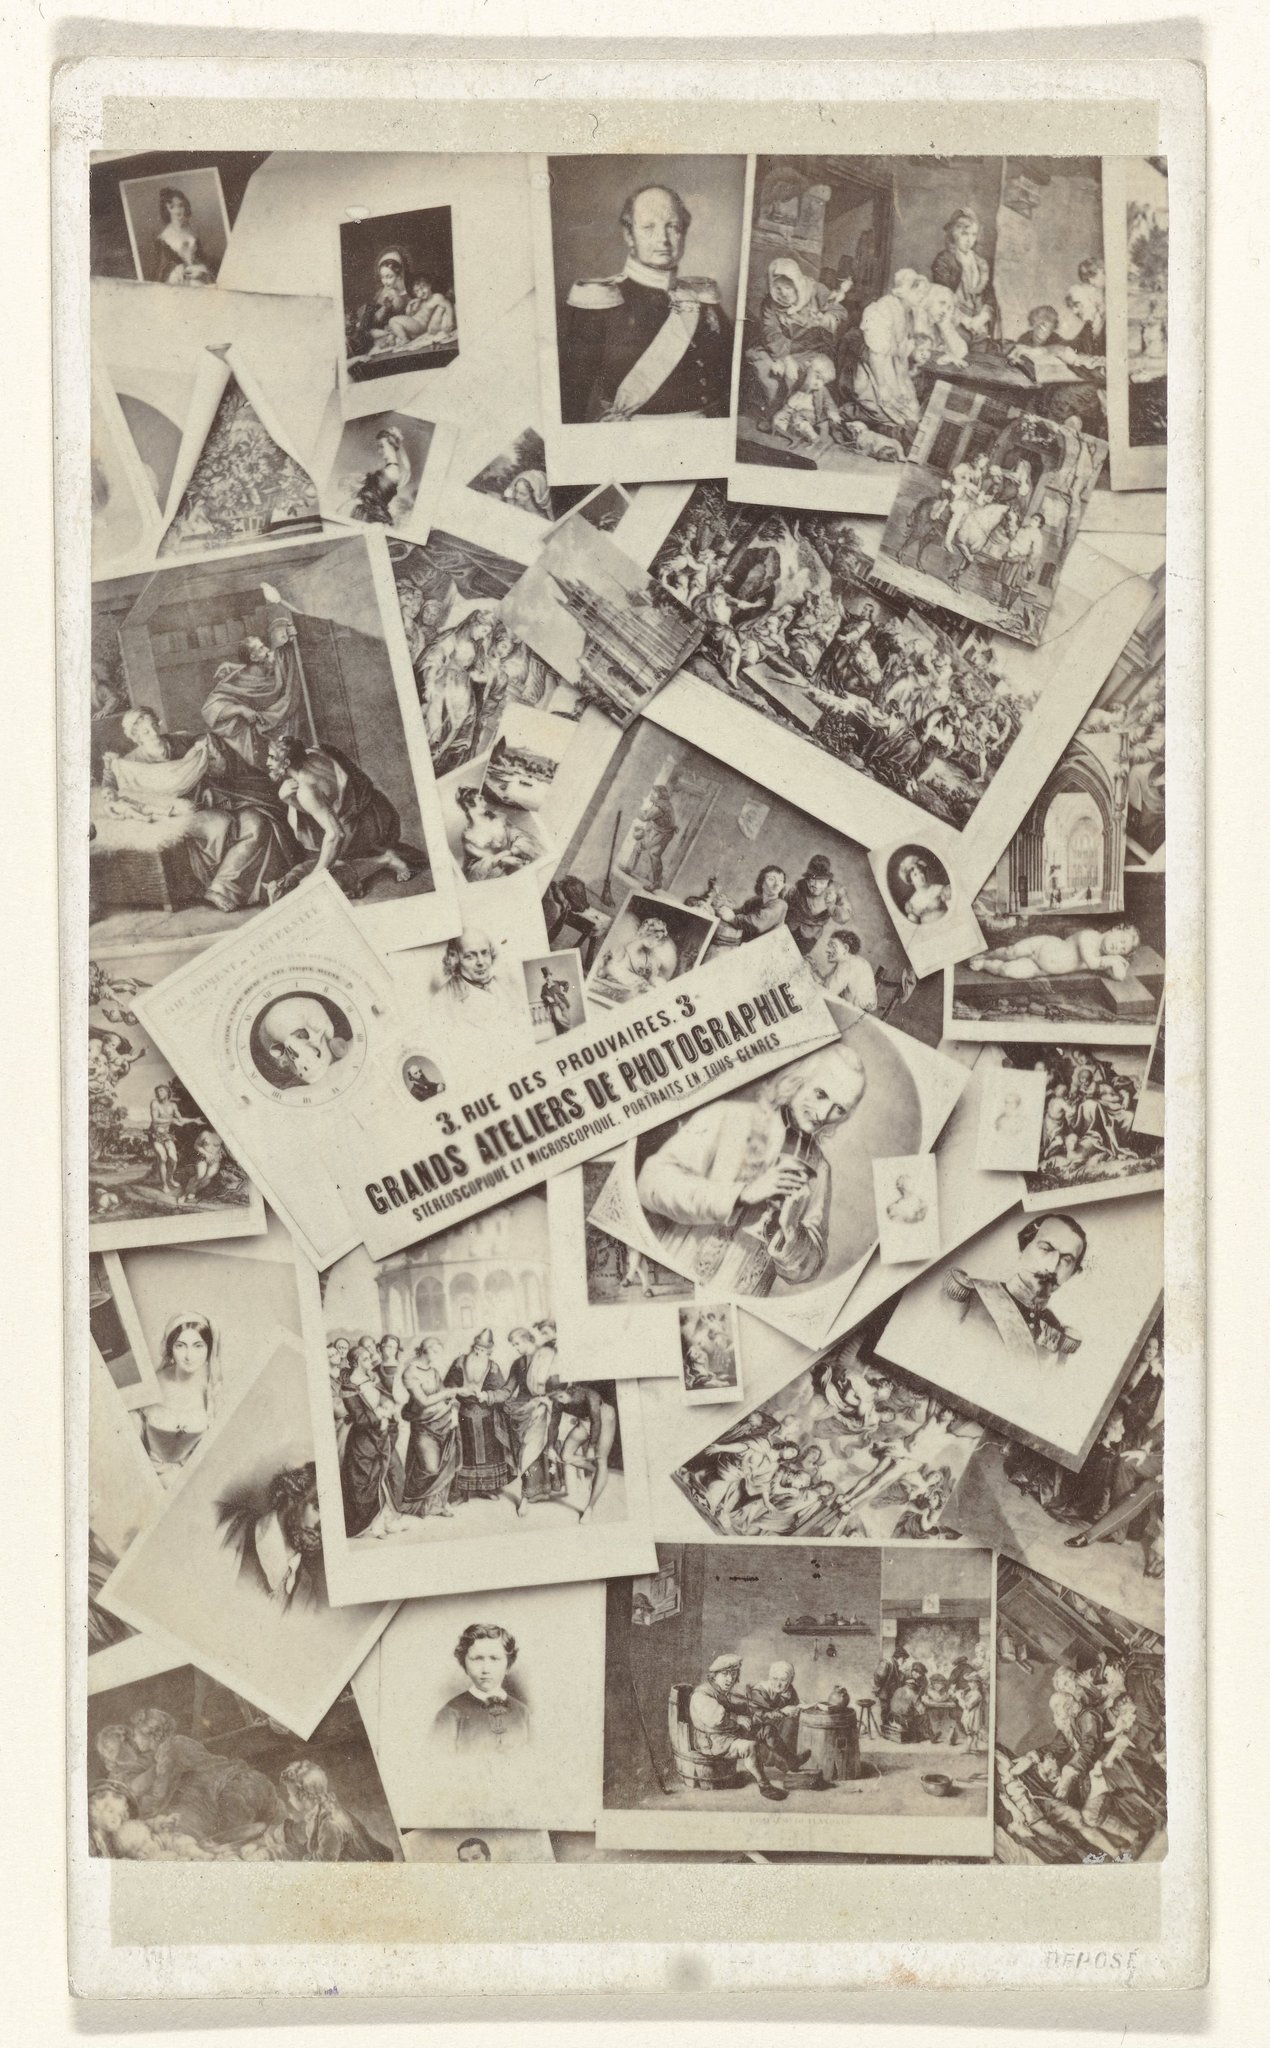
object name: carte de visite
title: Compositie van prenten en een vel tekst met het adres van de fotograaf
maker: jules raudnitz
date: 1860-1871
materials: paper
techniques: albumen print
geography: paris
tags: print, e.g.: engraving, etching, lithograph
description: Compositie van prenten, met een vel tekst met het adres van de fotograaf.